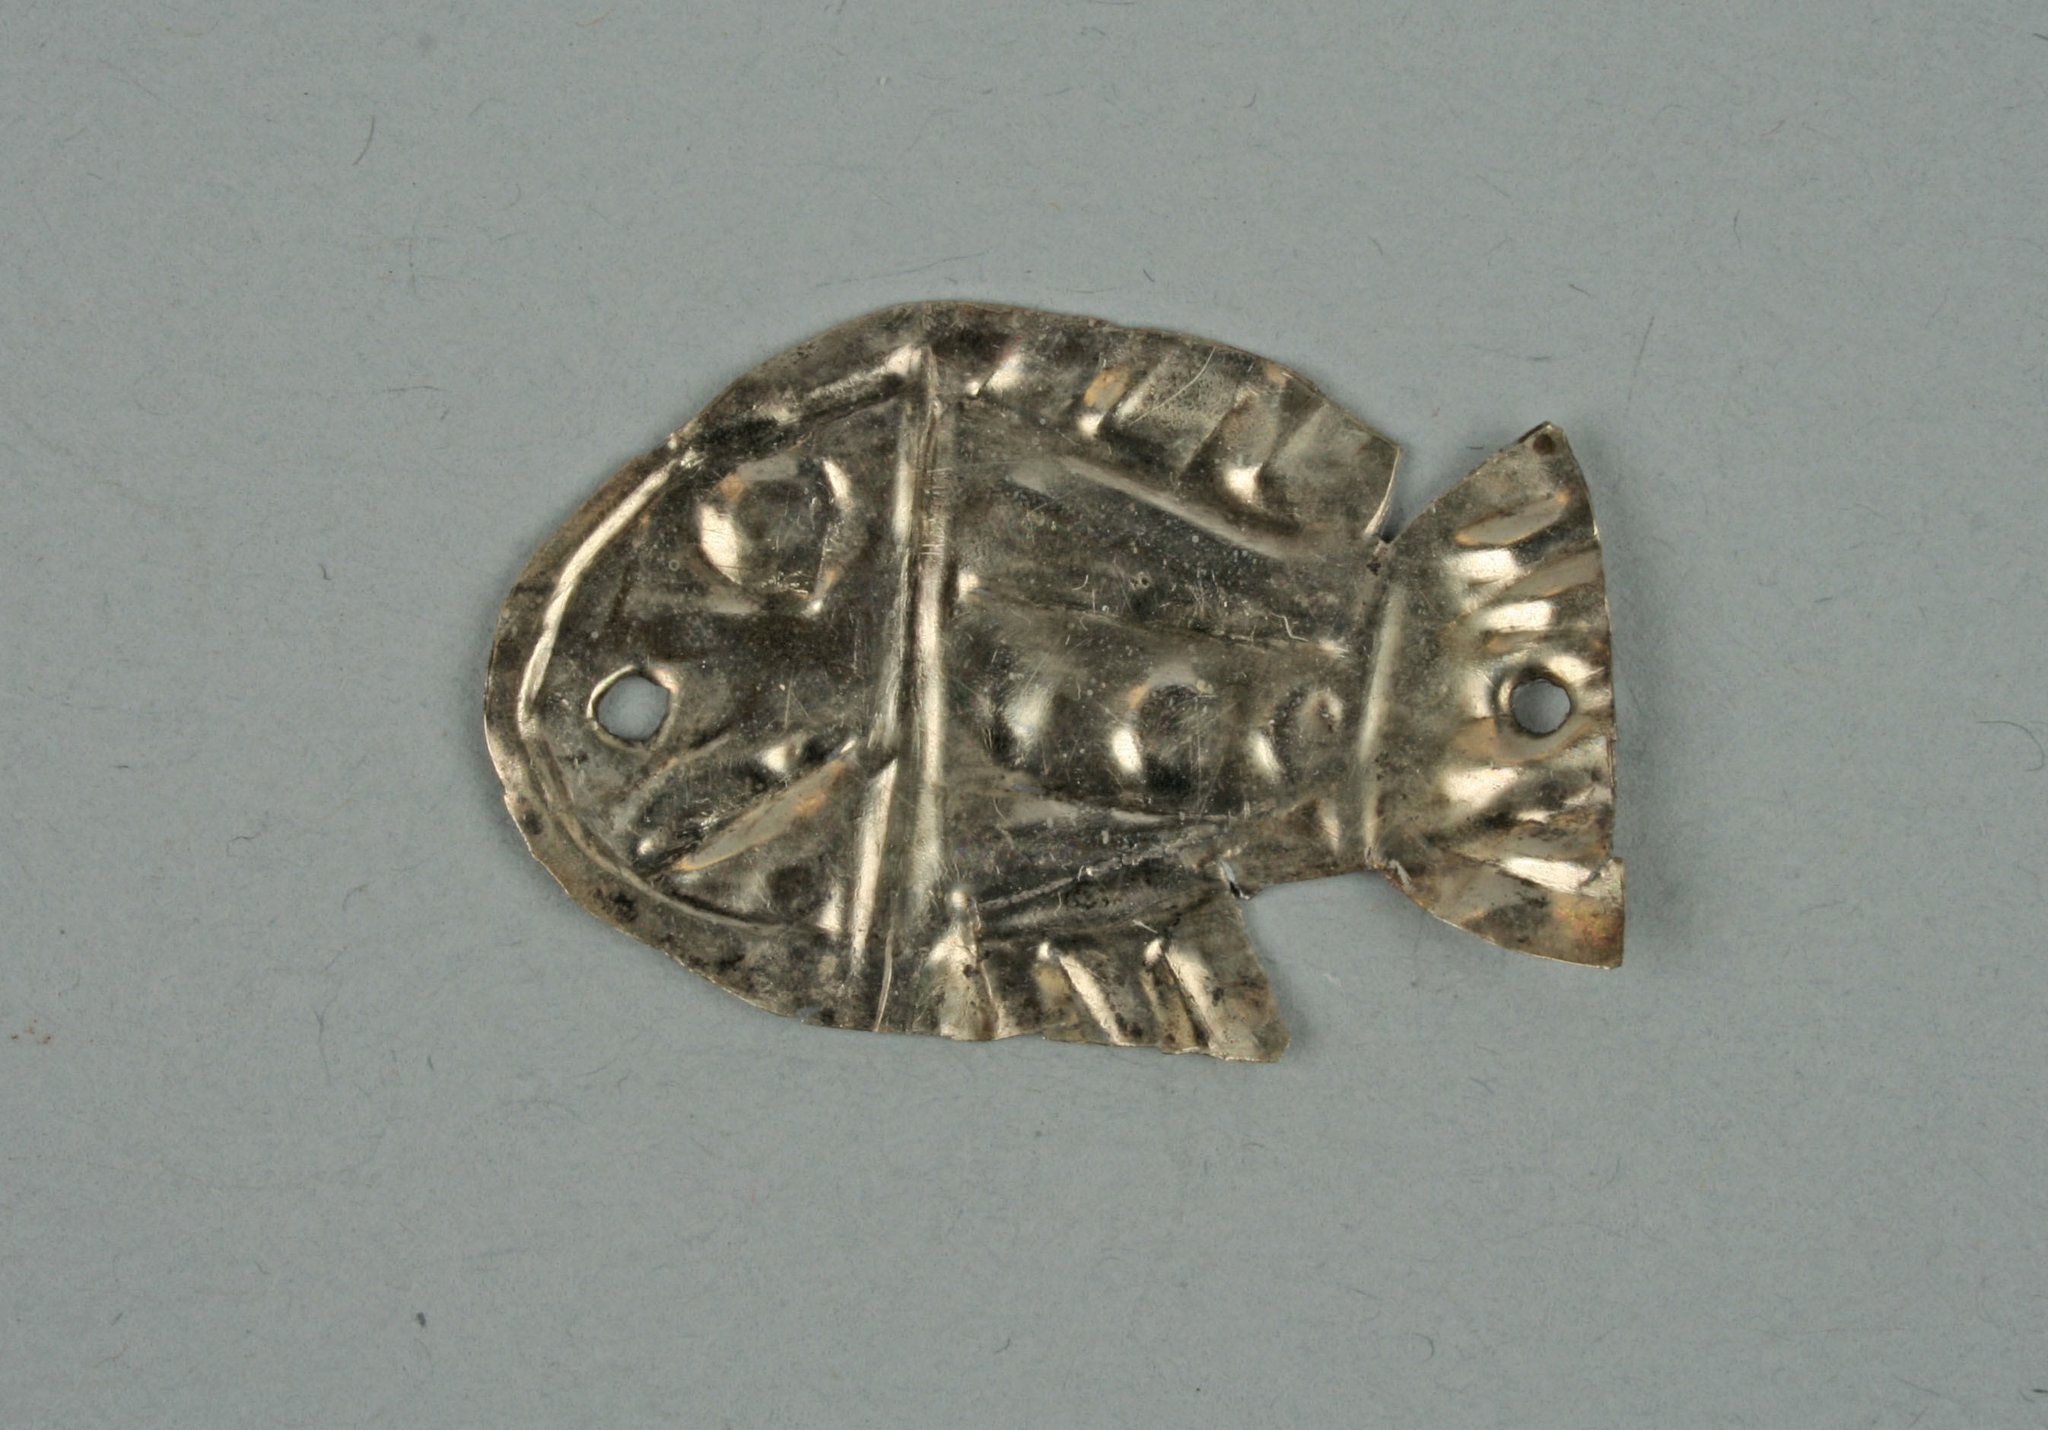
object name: ornament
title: Fish Ornament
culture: peruvian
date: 1001-1200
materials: silver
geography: peru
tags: fish